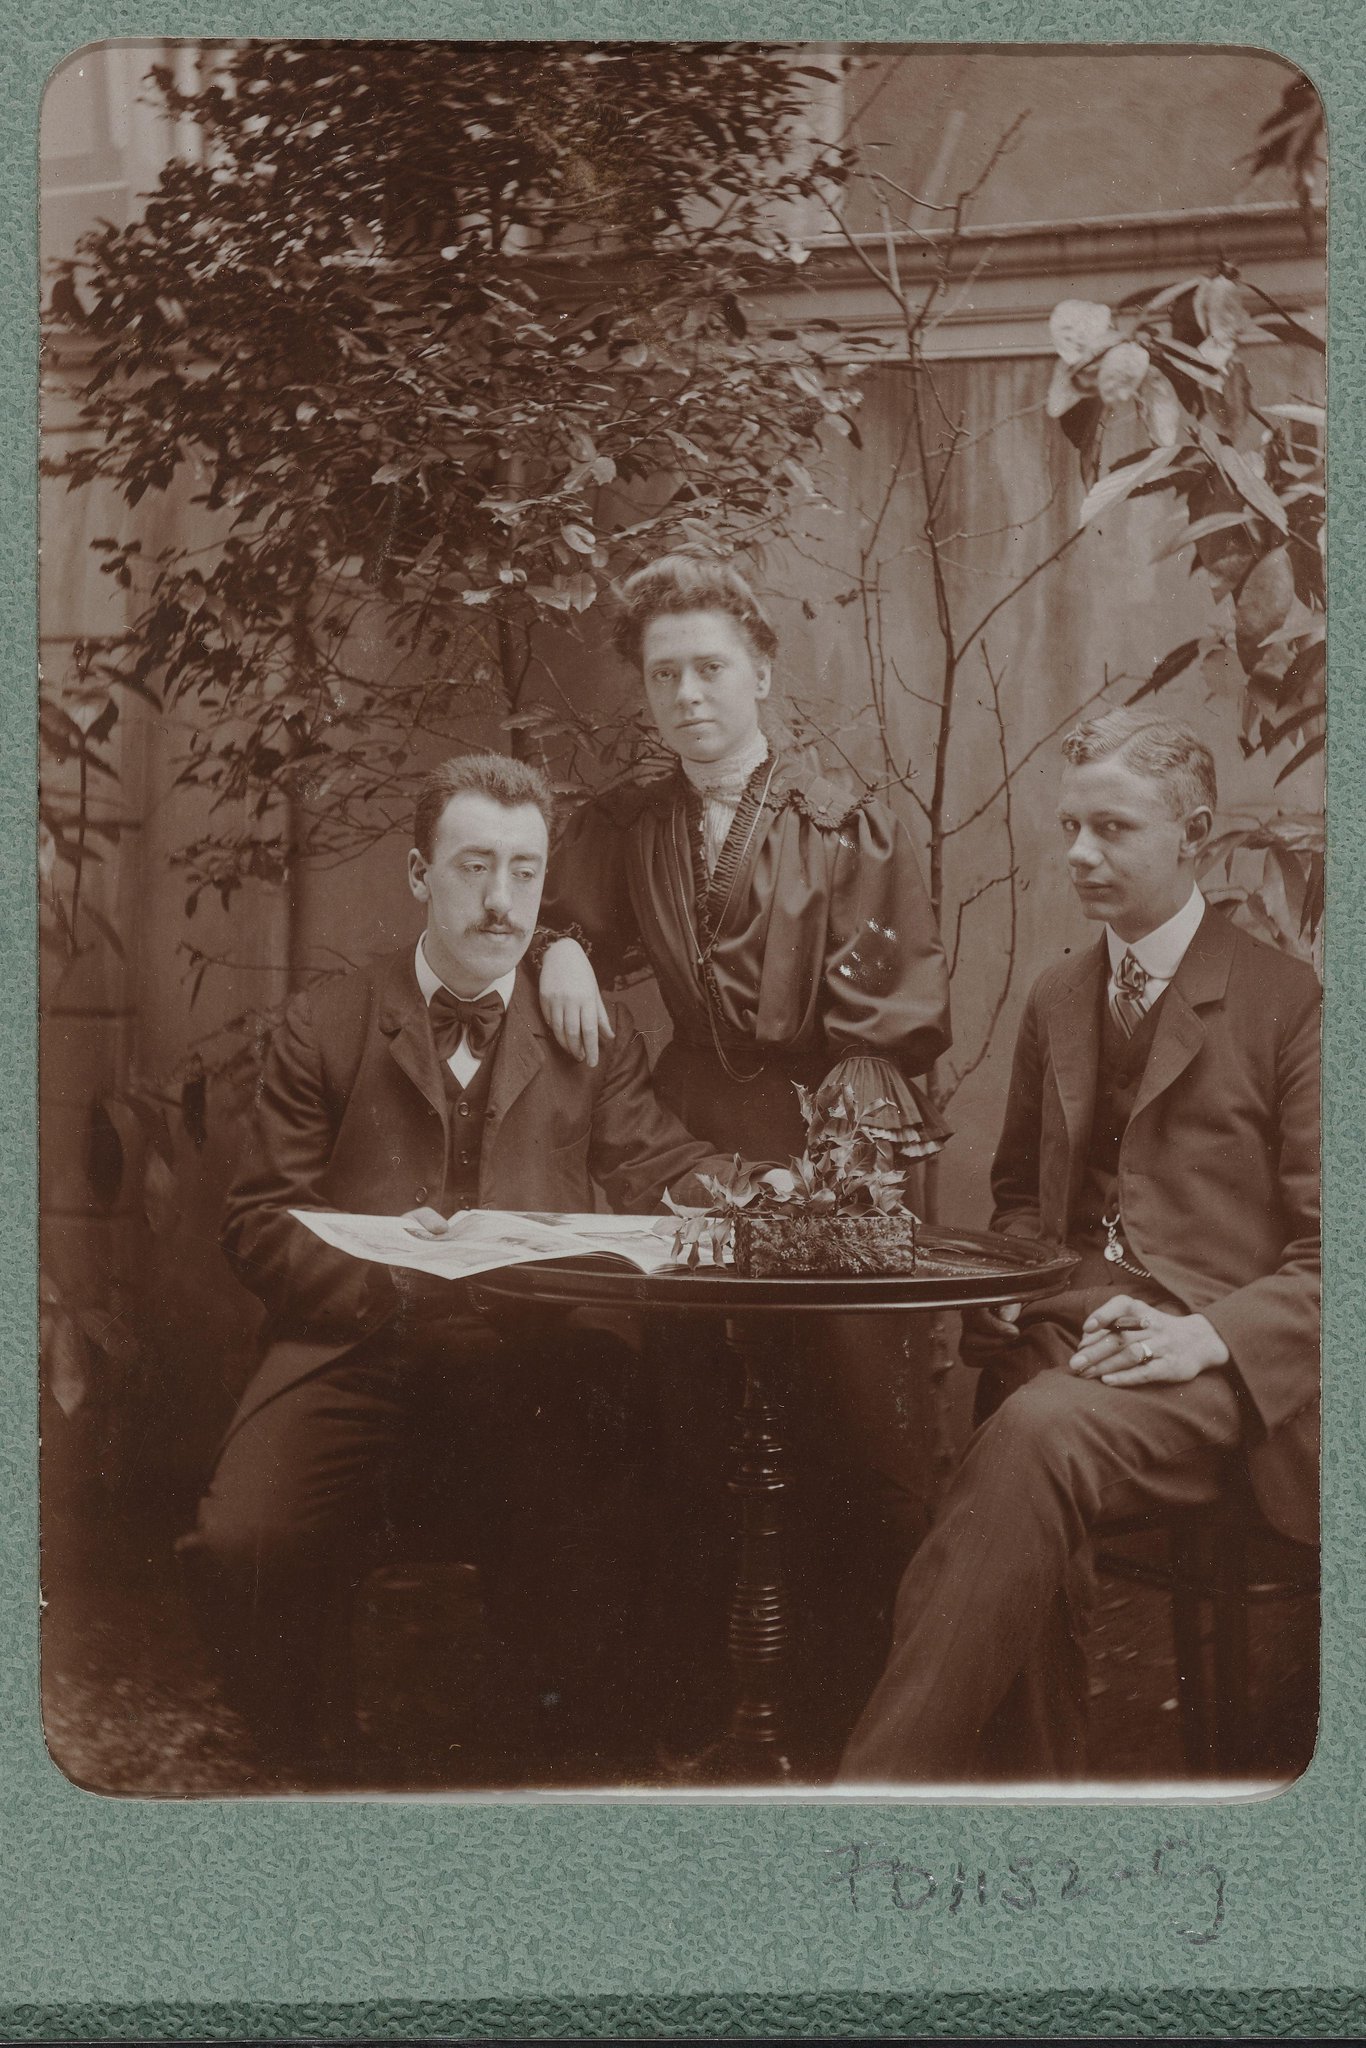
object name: photograph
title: Groepsportret met links Christiaan Otto Roelofs, een vrouw en een man rondom een tafel in de tuin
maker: christiaan otto roelofs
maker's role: fotograaf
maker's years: 1882-1970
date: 1900-1915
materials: photographic support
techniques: collodion silver print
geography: netherlands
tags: amsterdam, christiaan otto roelofs, adult man (+ two persons), adult woman, historical persons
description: De afgebeelde vrouw is mogelijk een zuster van Christiaan Otto Roelofs.